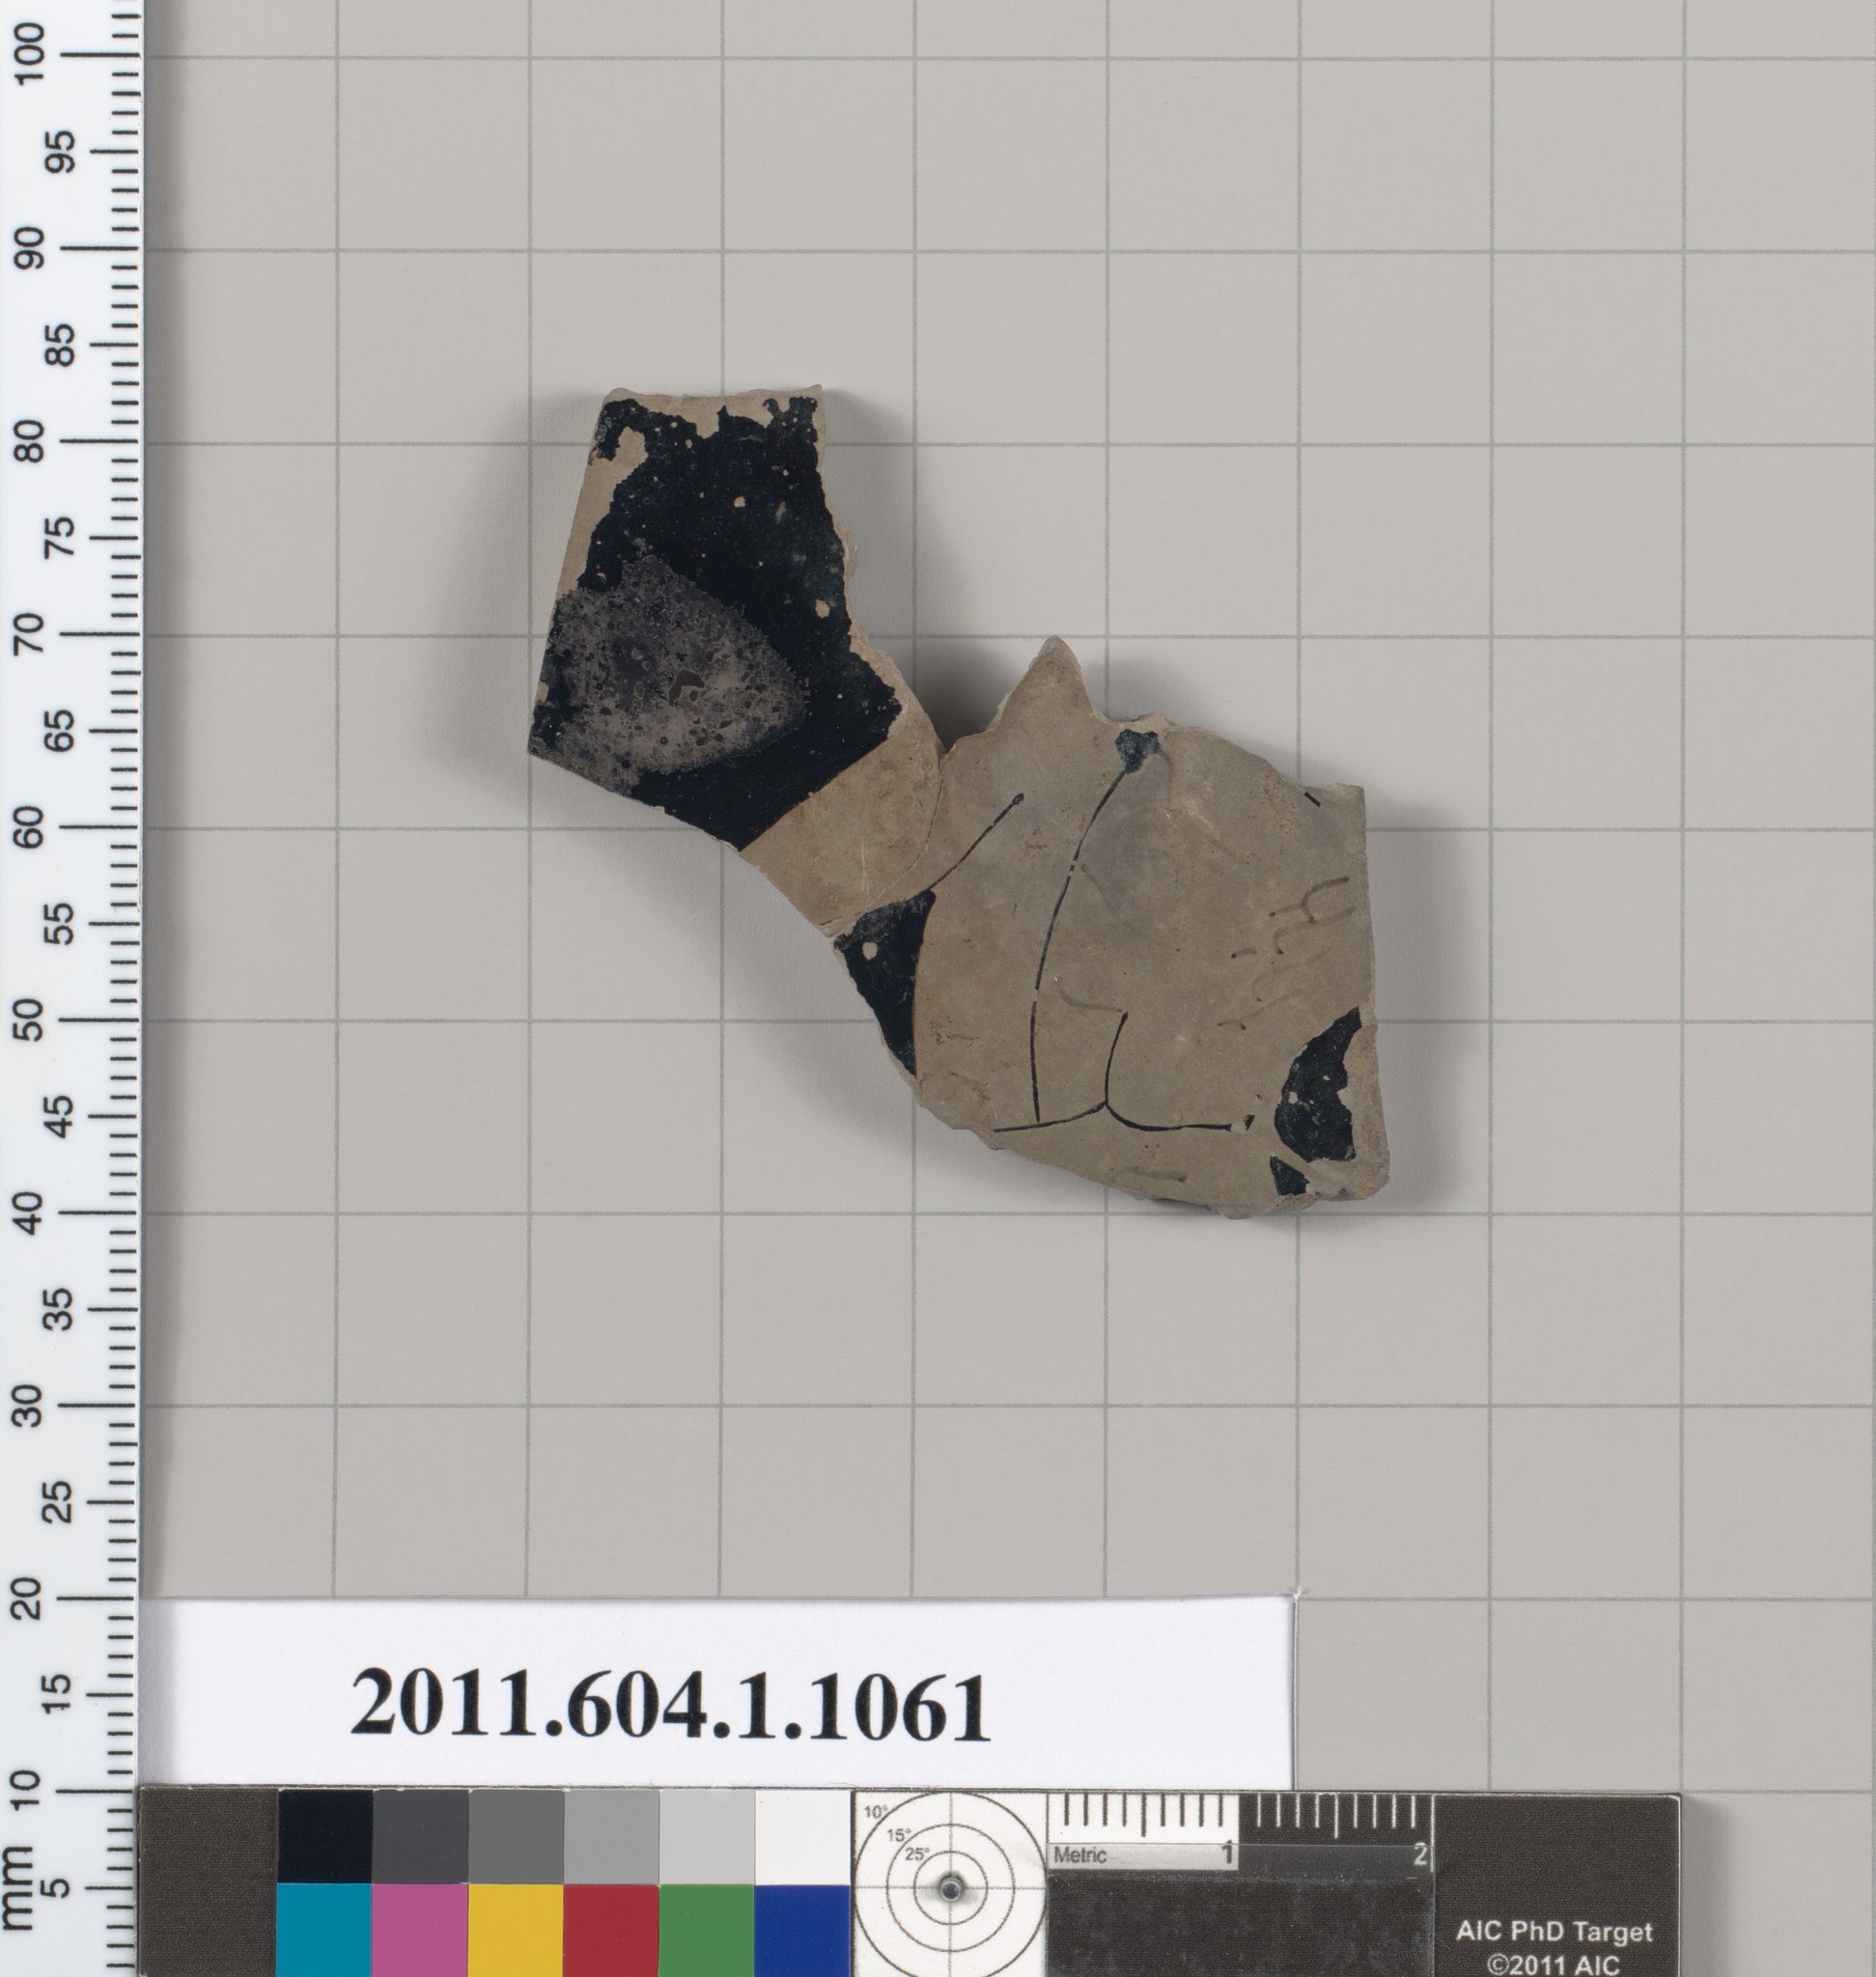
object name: kylix fragment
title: Terracotta fragment of a kylix (drinking cup)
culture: greek, attic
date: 475-451 BCE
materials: terracotta